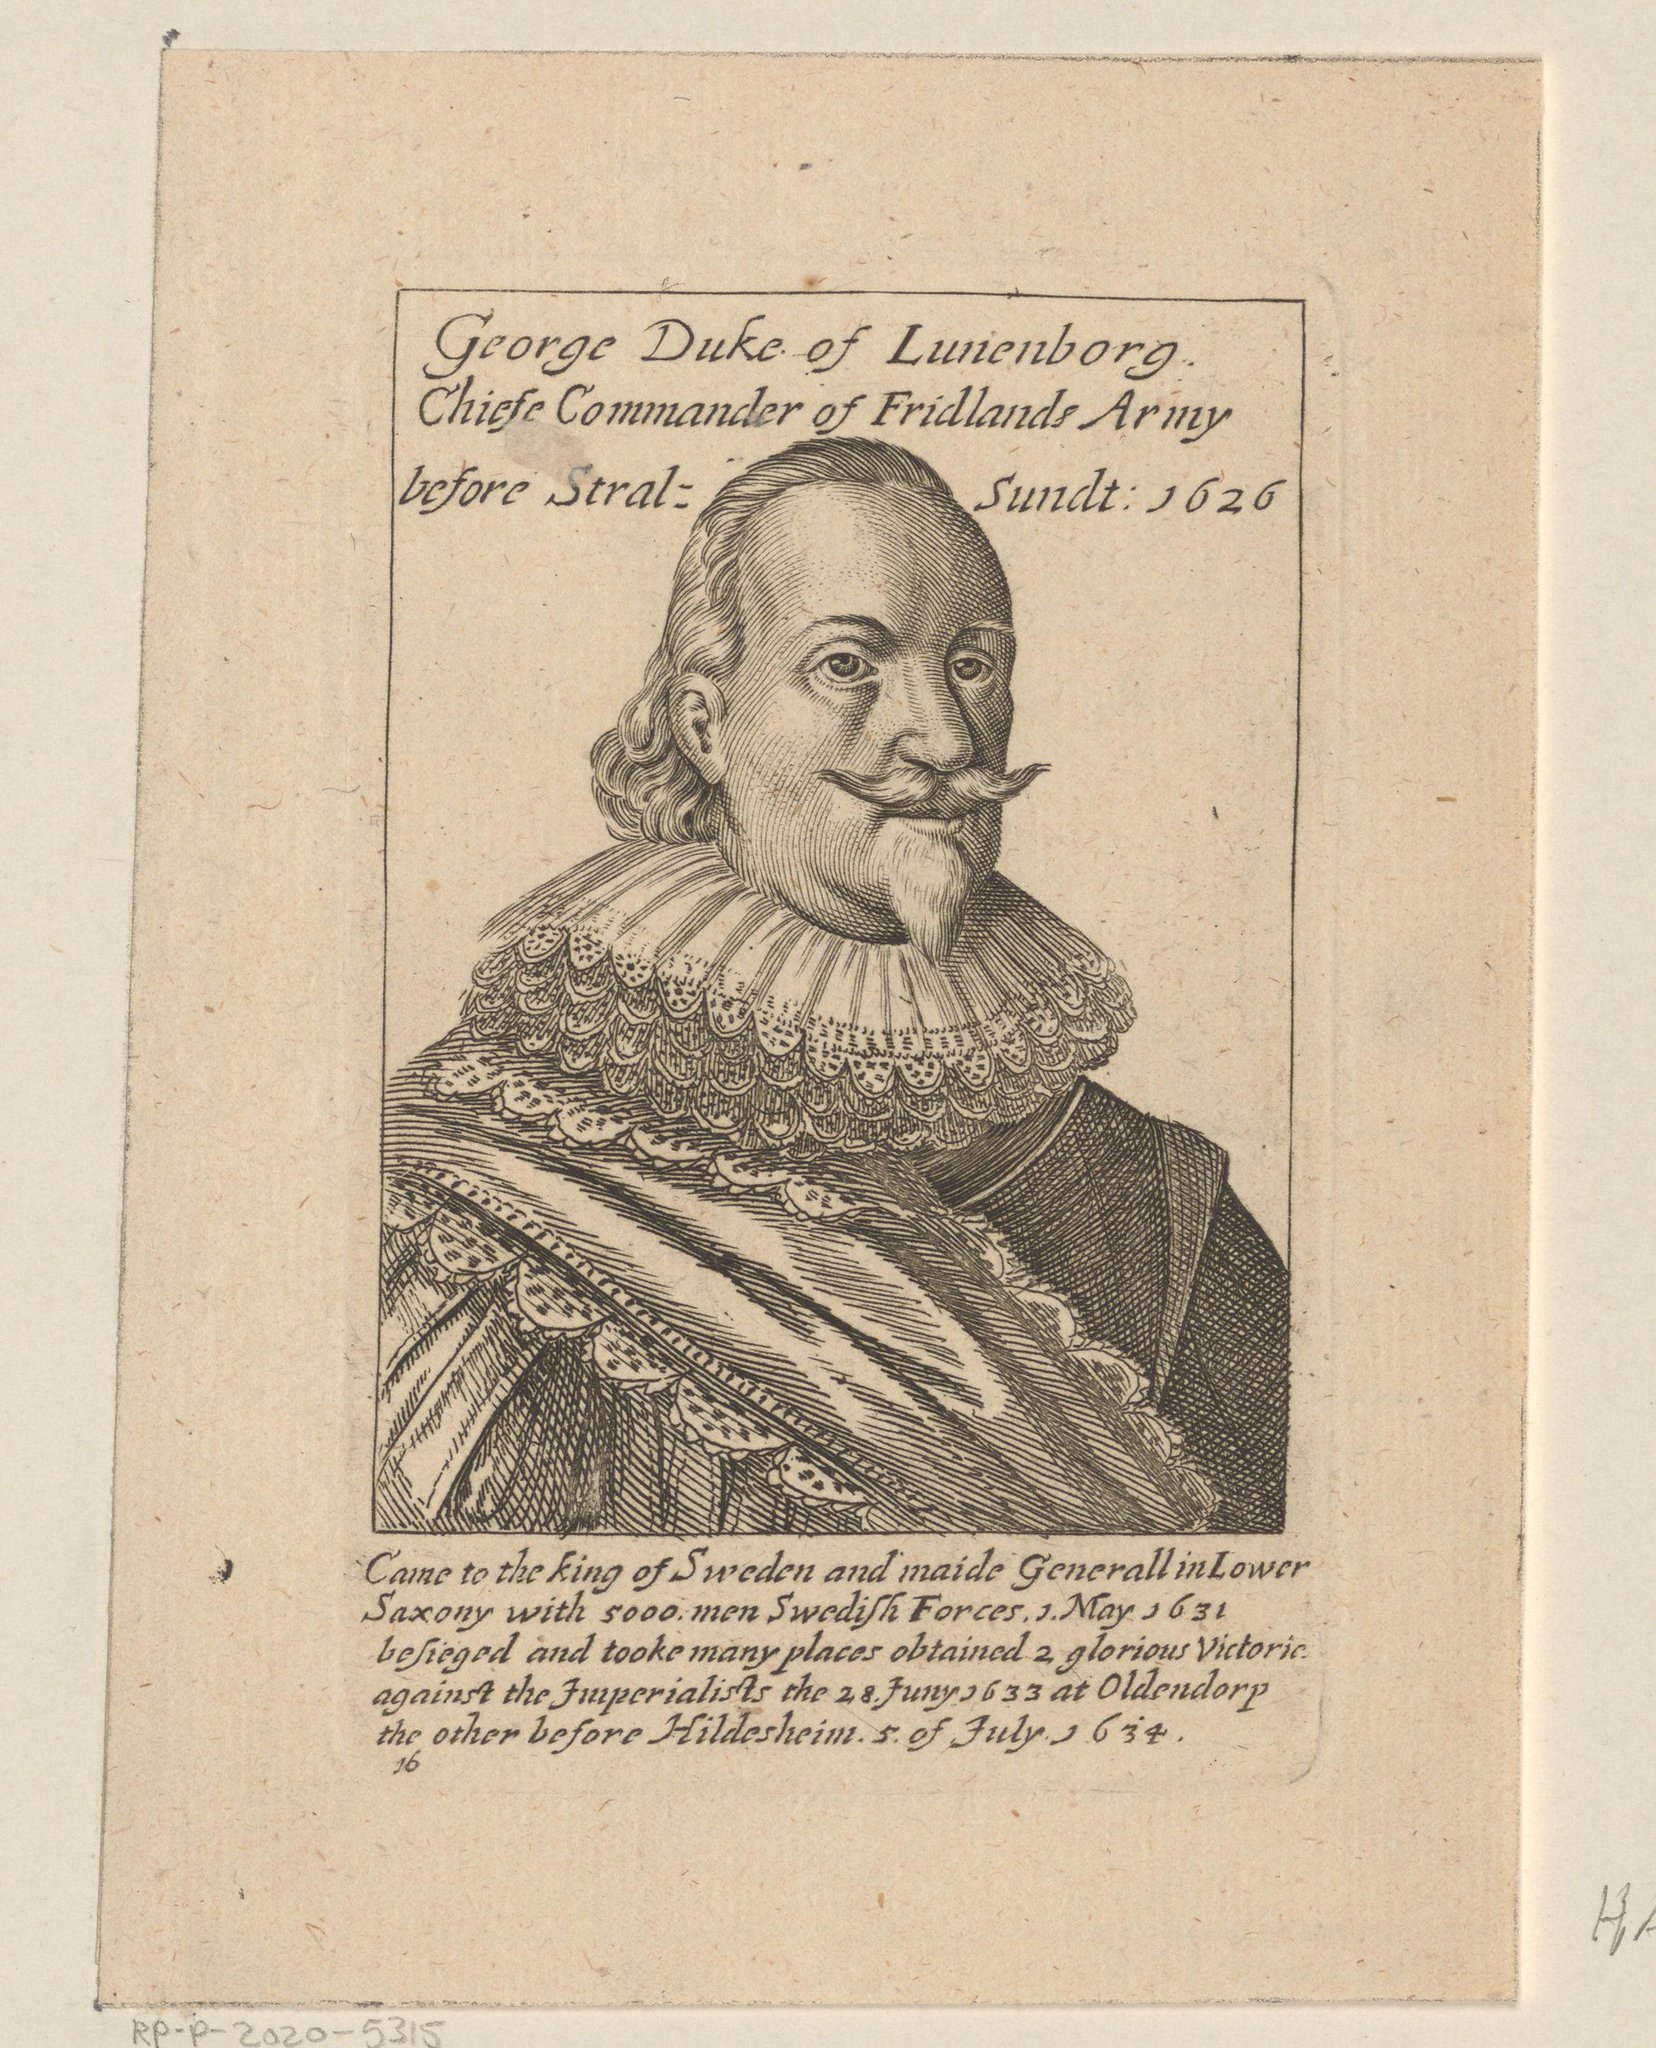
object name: print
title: Portret van Georg van Brunswijk-Calenberg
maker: Anonymous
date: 1600-1638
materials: paper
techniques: engraving, etching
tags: historical persons, politician, e.g. party leader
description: Andere staat van prent gebruikt in: The invasions of Germanie. Londen: John Rothwell, 1638.